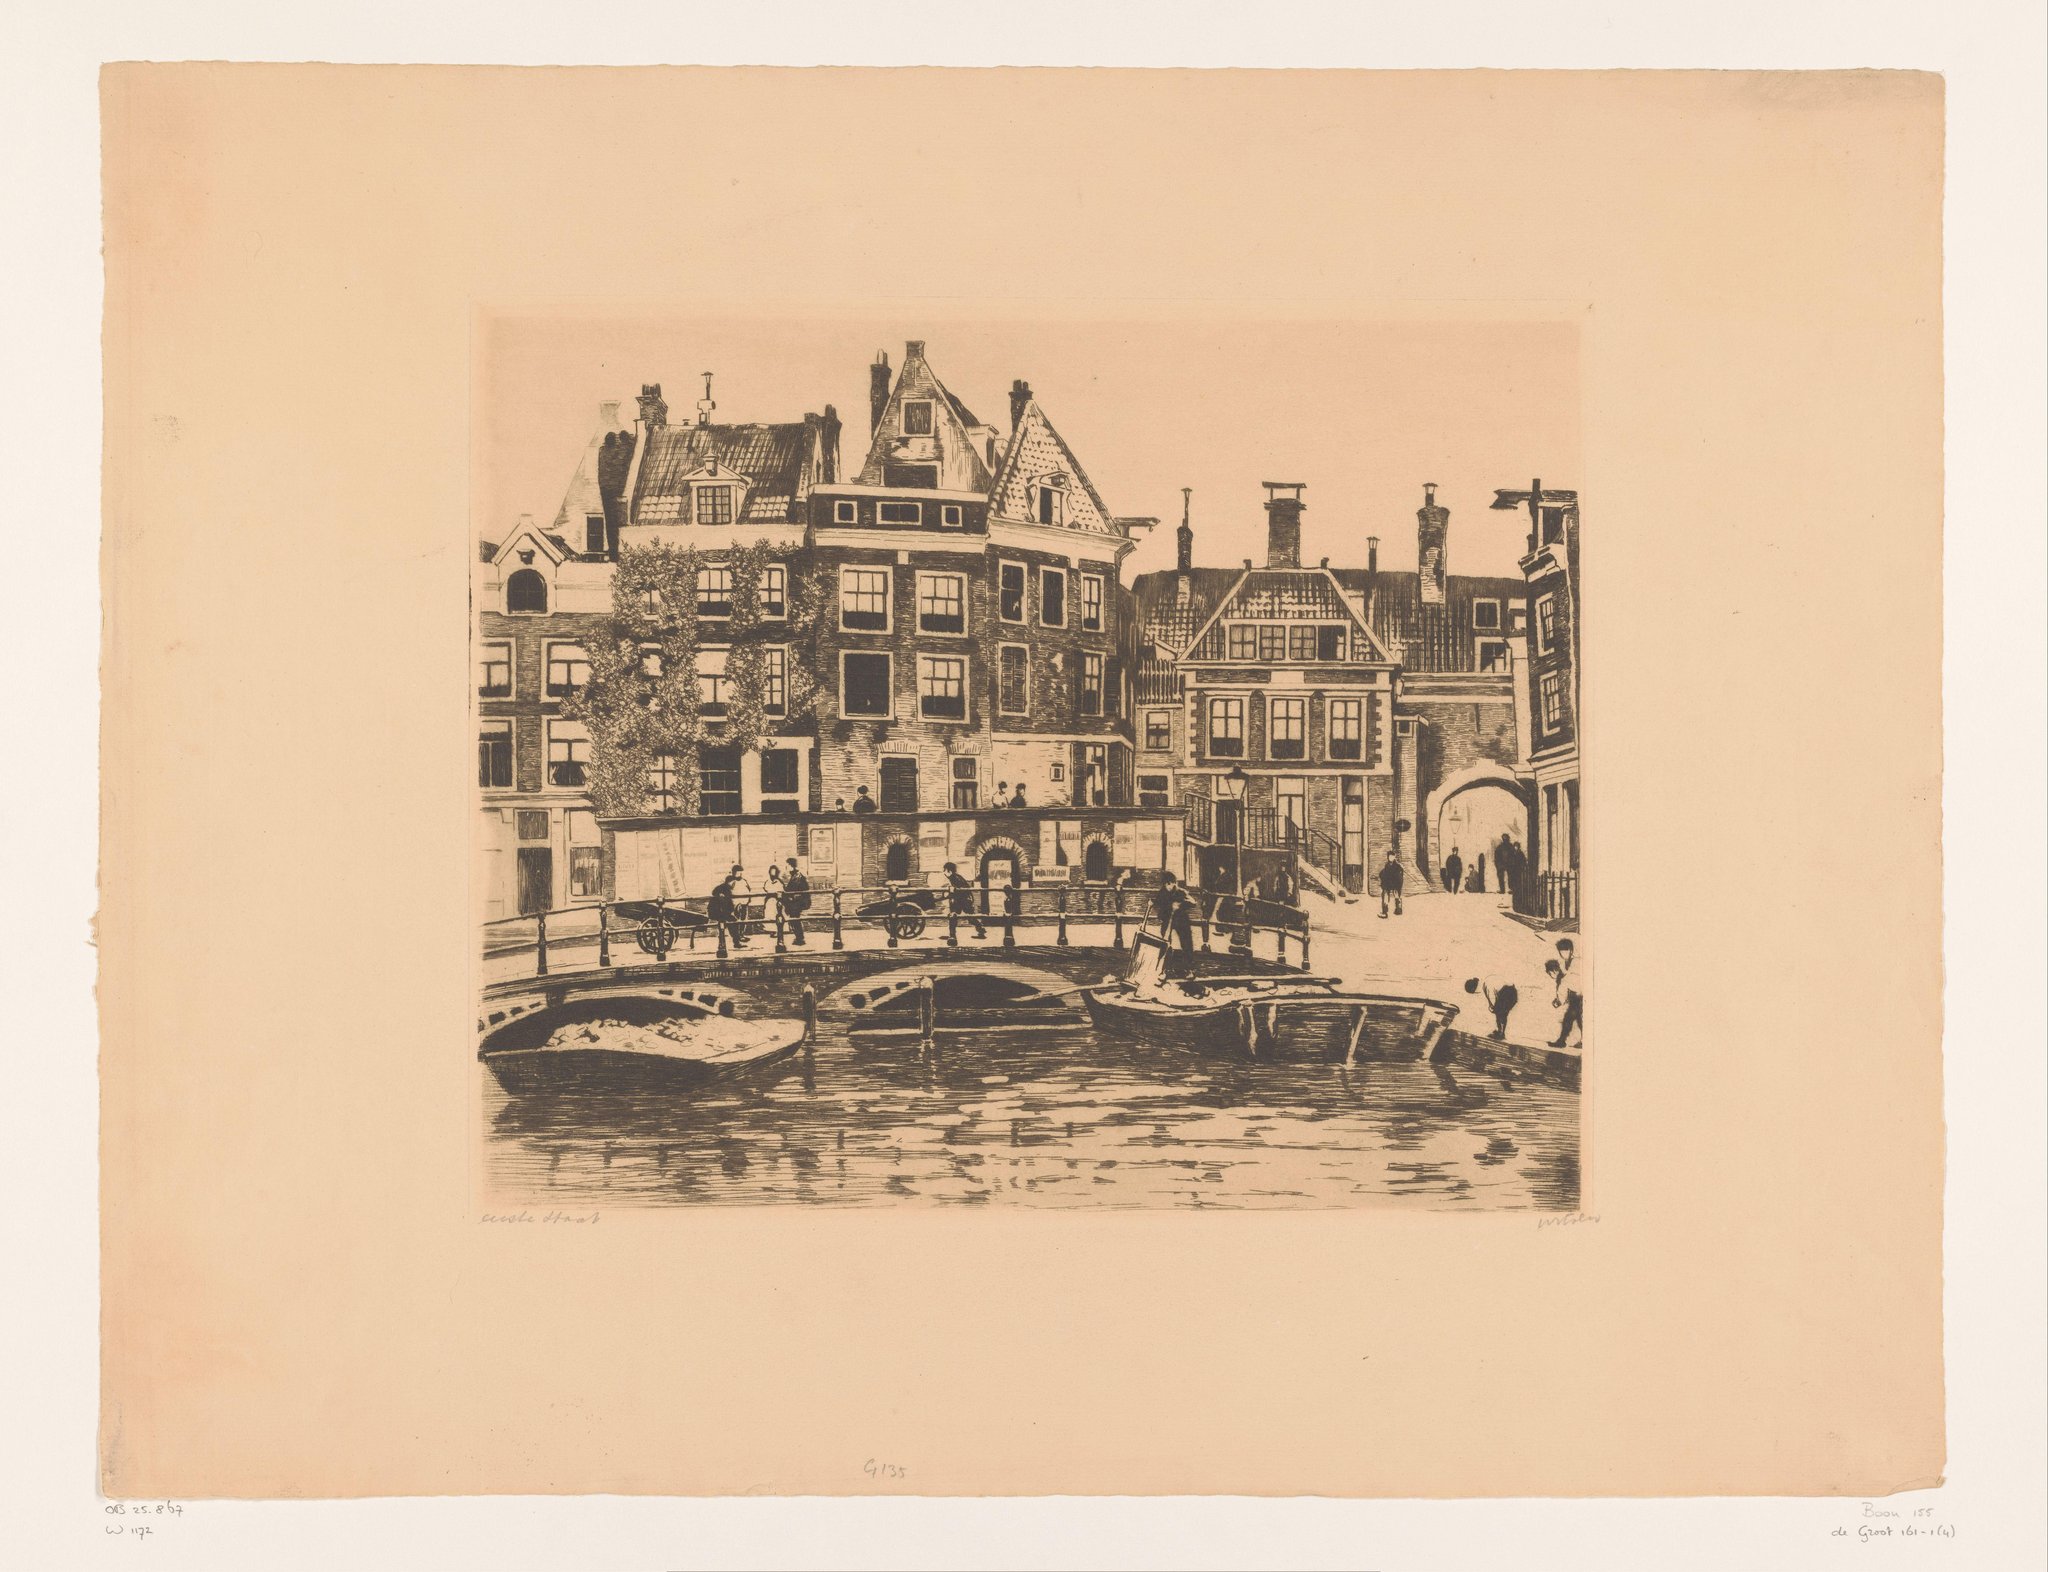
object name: print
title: Beurspoortje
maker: willem witsen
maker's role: draughtsman, painter, print maker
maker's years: 1860-1923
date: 1911-1912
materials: paper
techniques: etching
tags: hand-cart, urban housing, rowing-boat, canoe, etc., canals, waters (in city)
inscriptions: annotation: ‘eerste staat’